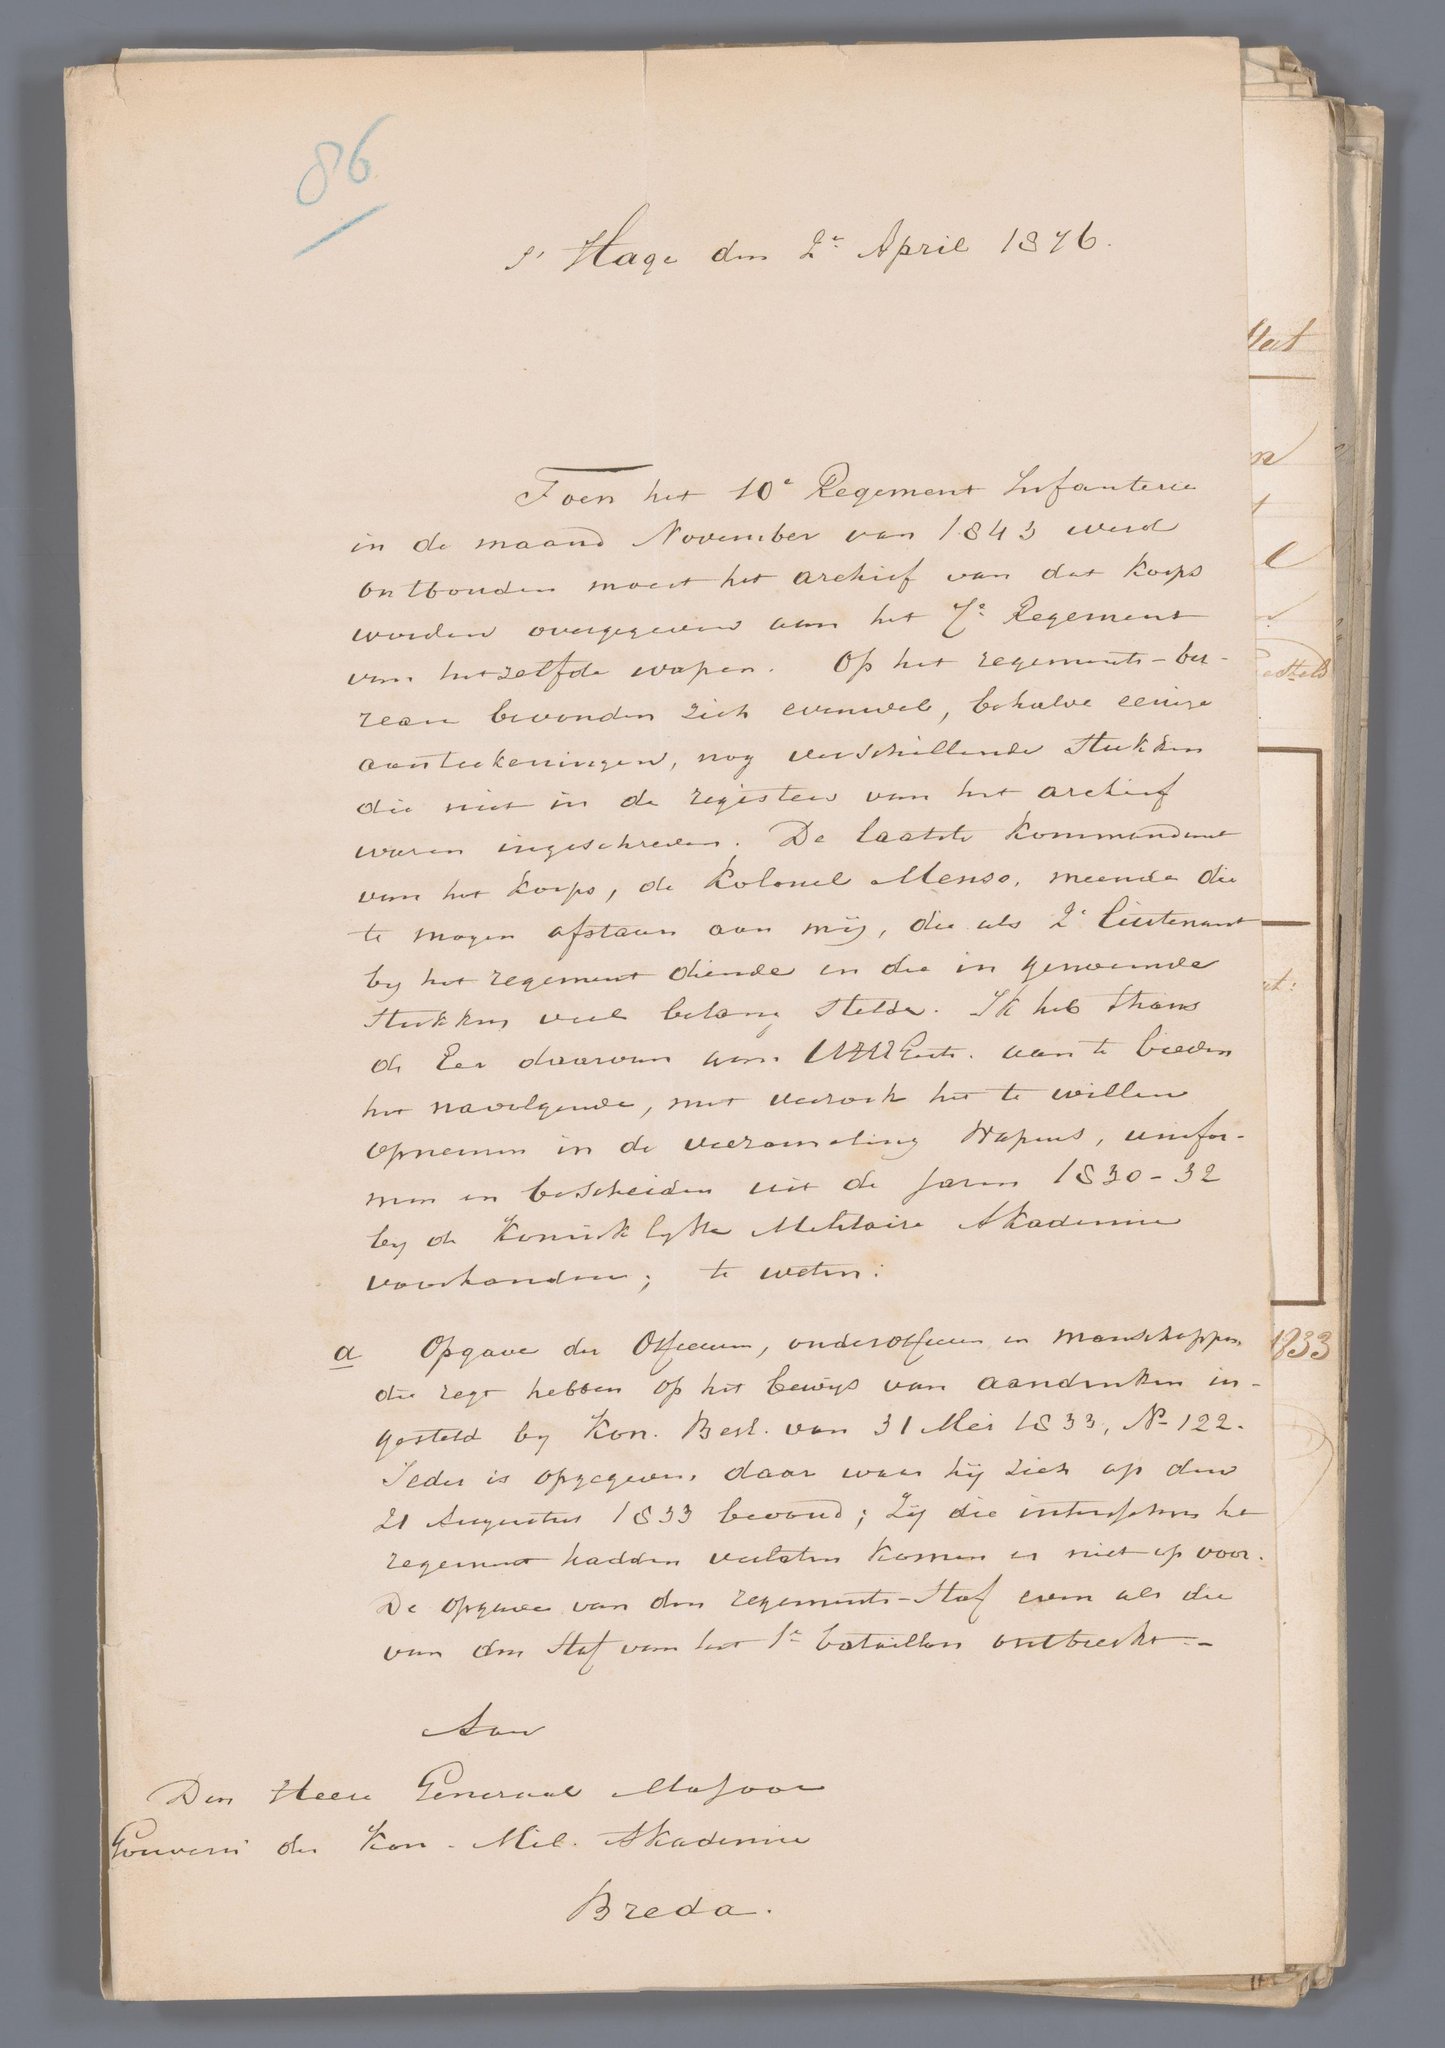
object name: file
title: Dossier met handgeschreven documenten door gen.-maj. Weitzel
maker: Anonymous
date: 1803-1830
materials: ink, paper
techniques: sewing, writing